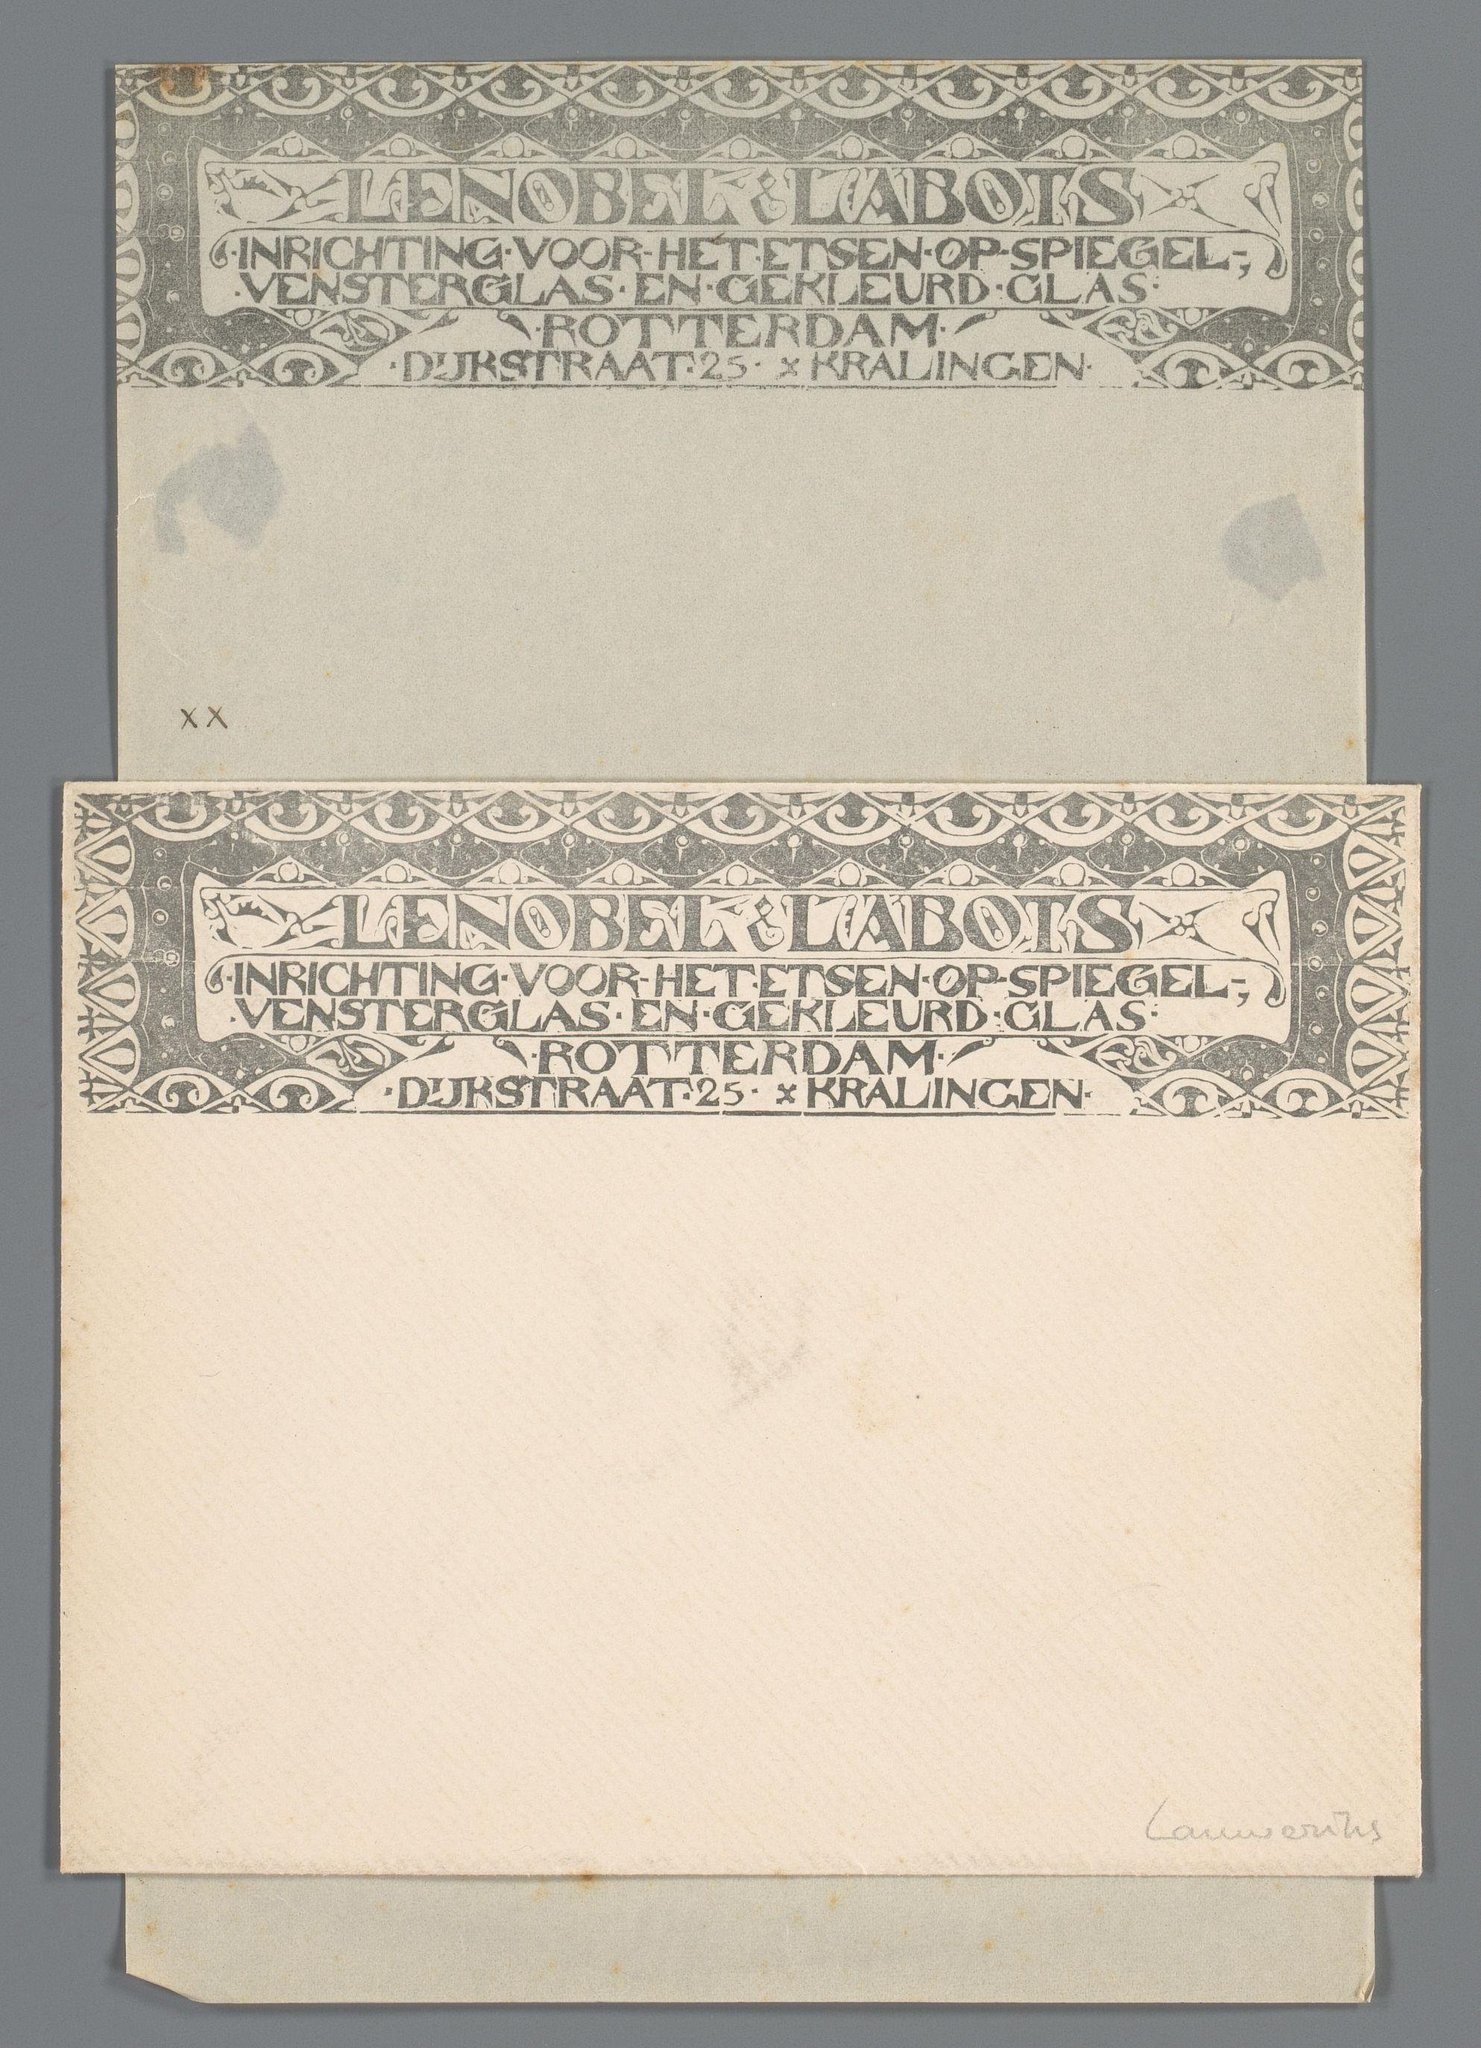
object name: stationery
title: Envelop waaraan vastgeplakt een vel briefpapier, beide met het vignet van Le Noble en Labots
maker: mathieu lauweriks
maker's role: designer, draughtsman, print maker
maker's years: 1864-1932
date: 1890-1900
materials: paper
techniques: woodcut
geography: amsterdam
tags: fantasy ornament, rotterdam